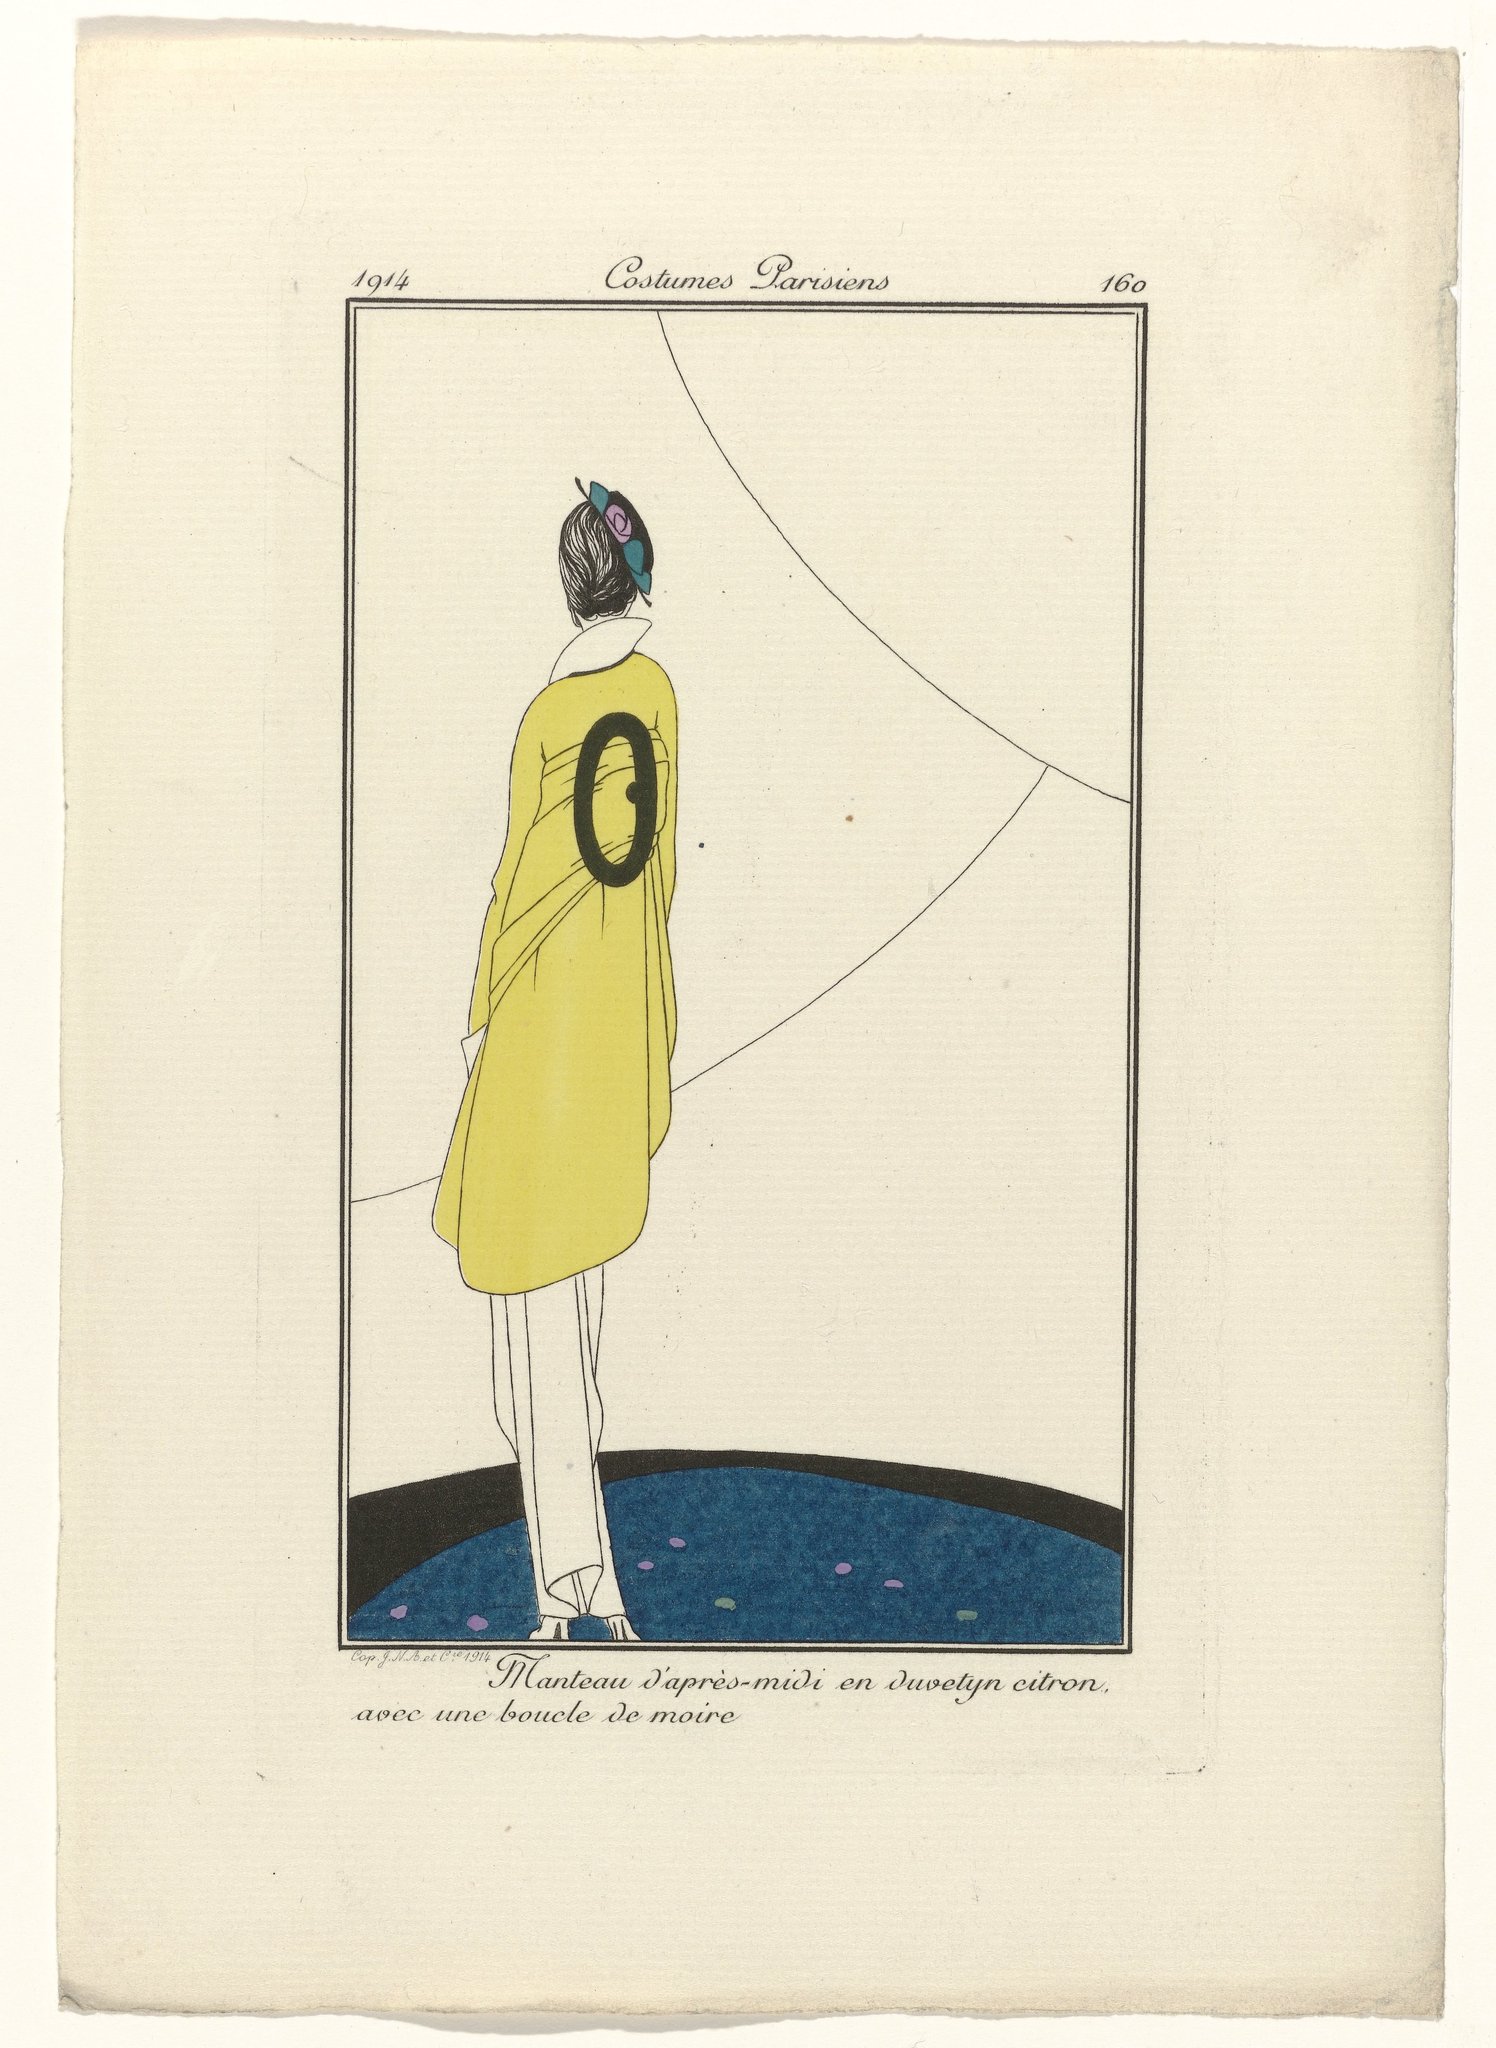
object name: fashion print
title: Journal des Dames et des Modes, Costumes Parisiens, 1914, No. 160 : Manteau d'après-midi, (...)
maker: Anonymous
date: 1914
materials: paper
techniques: engraving, hand coloring, pochoir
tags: buckle (+ women's clothes), coat (+ women's clothes), head-gear (+ women's clothes), fashion plates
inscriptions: title: ‘Costumes Parisiens’, inscription: ‘Cop. J. N. A. et Cie 1914’, caption: ‘Manteau d'après-midi, en duvetyn citron, avec une boucle de moire.’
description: Mantel voor de middag van citroengeel 'duvetyne' met een gesp van 'moire'. Prent uit het modetijdschrift Journal des Dames et des Modes (1912-1914).